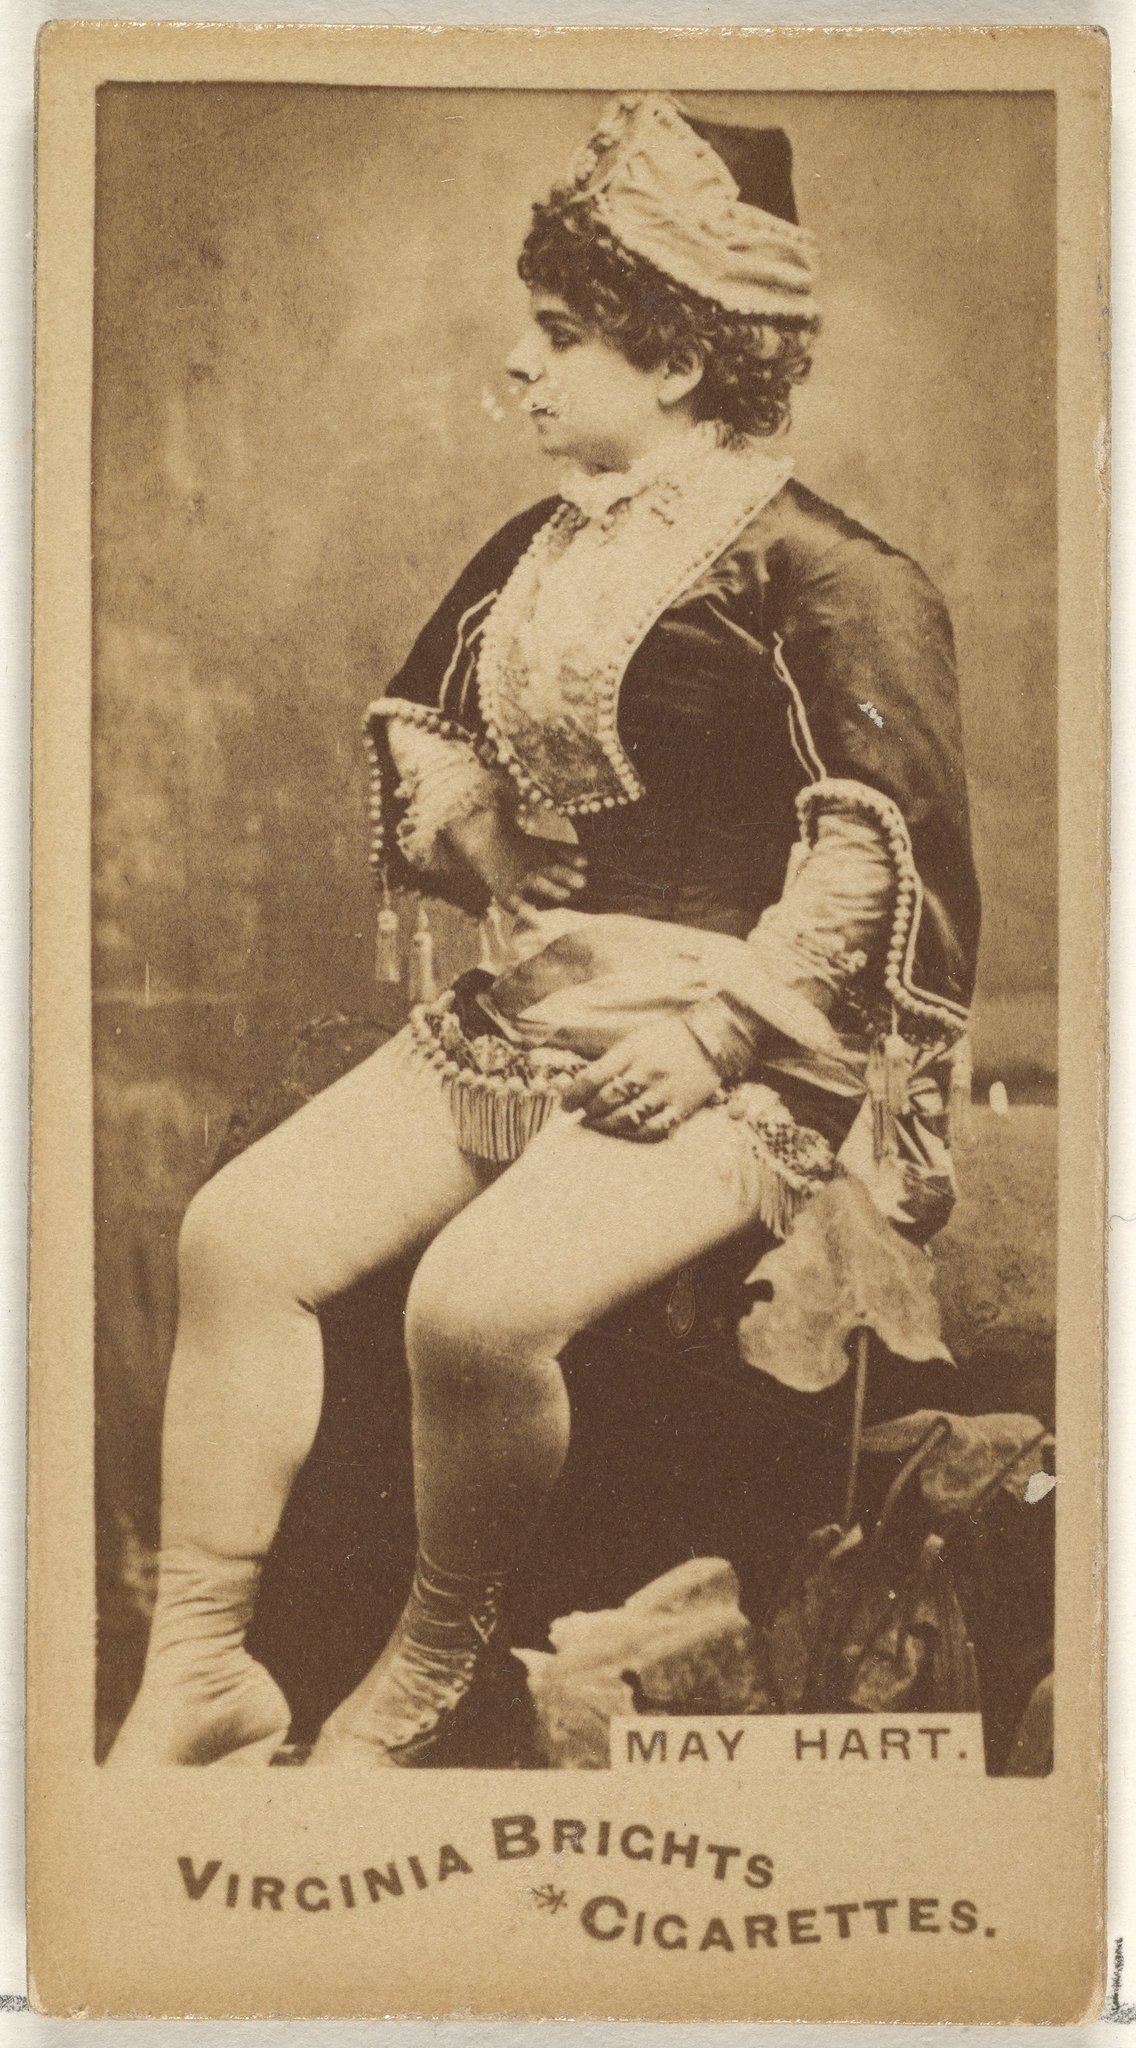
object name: photograph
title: May Hart, from the Actors and Actresses series (N45, Type 1) for Virginia Brights Cigarettes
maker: allen & ginter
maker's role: publisher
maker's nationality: american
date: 1888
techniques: albumen silver print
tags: portraits,profiles,women,actresses